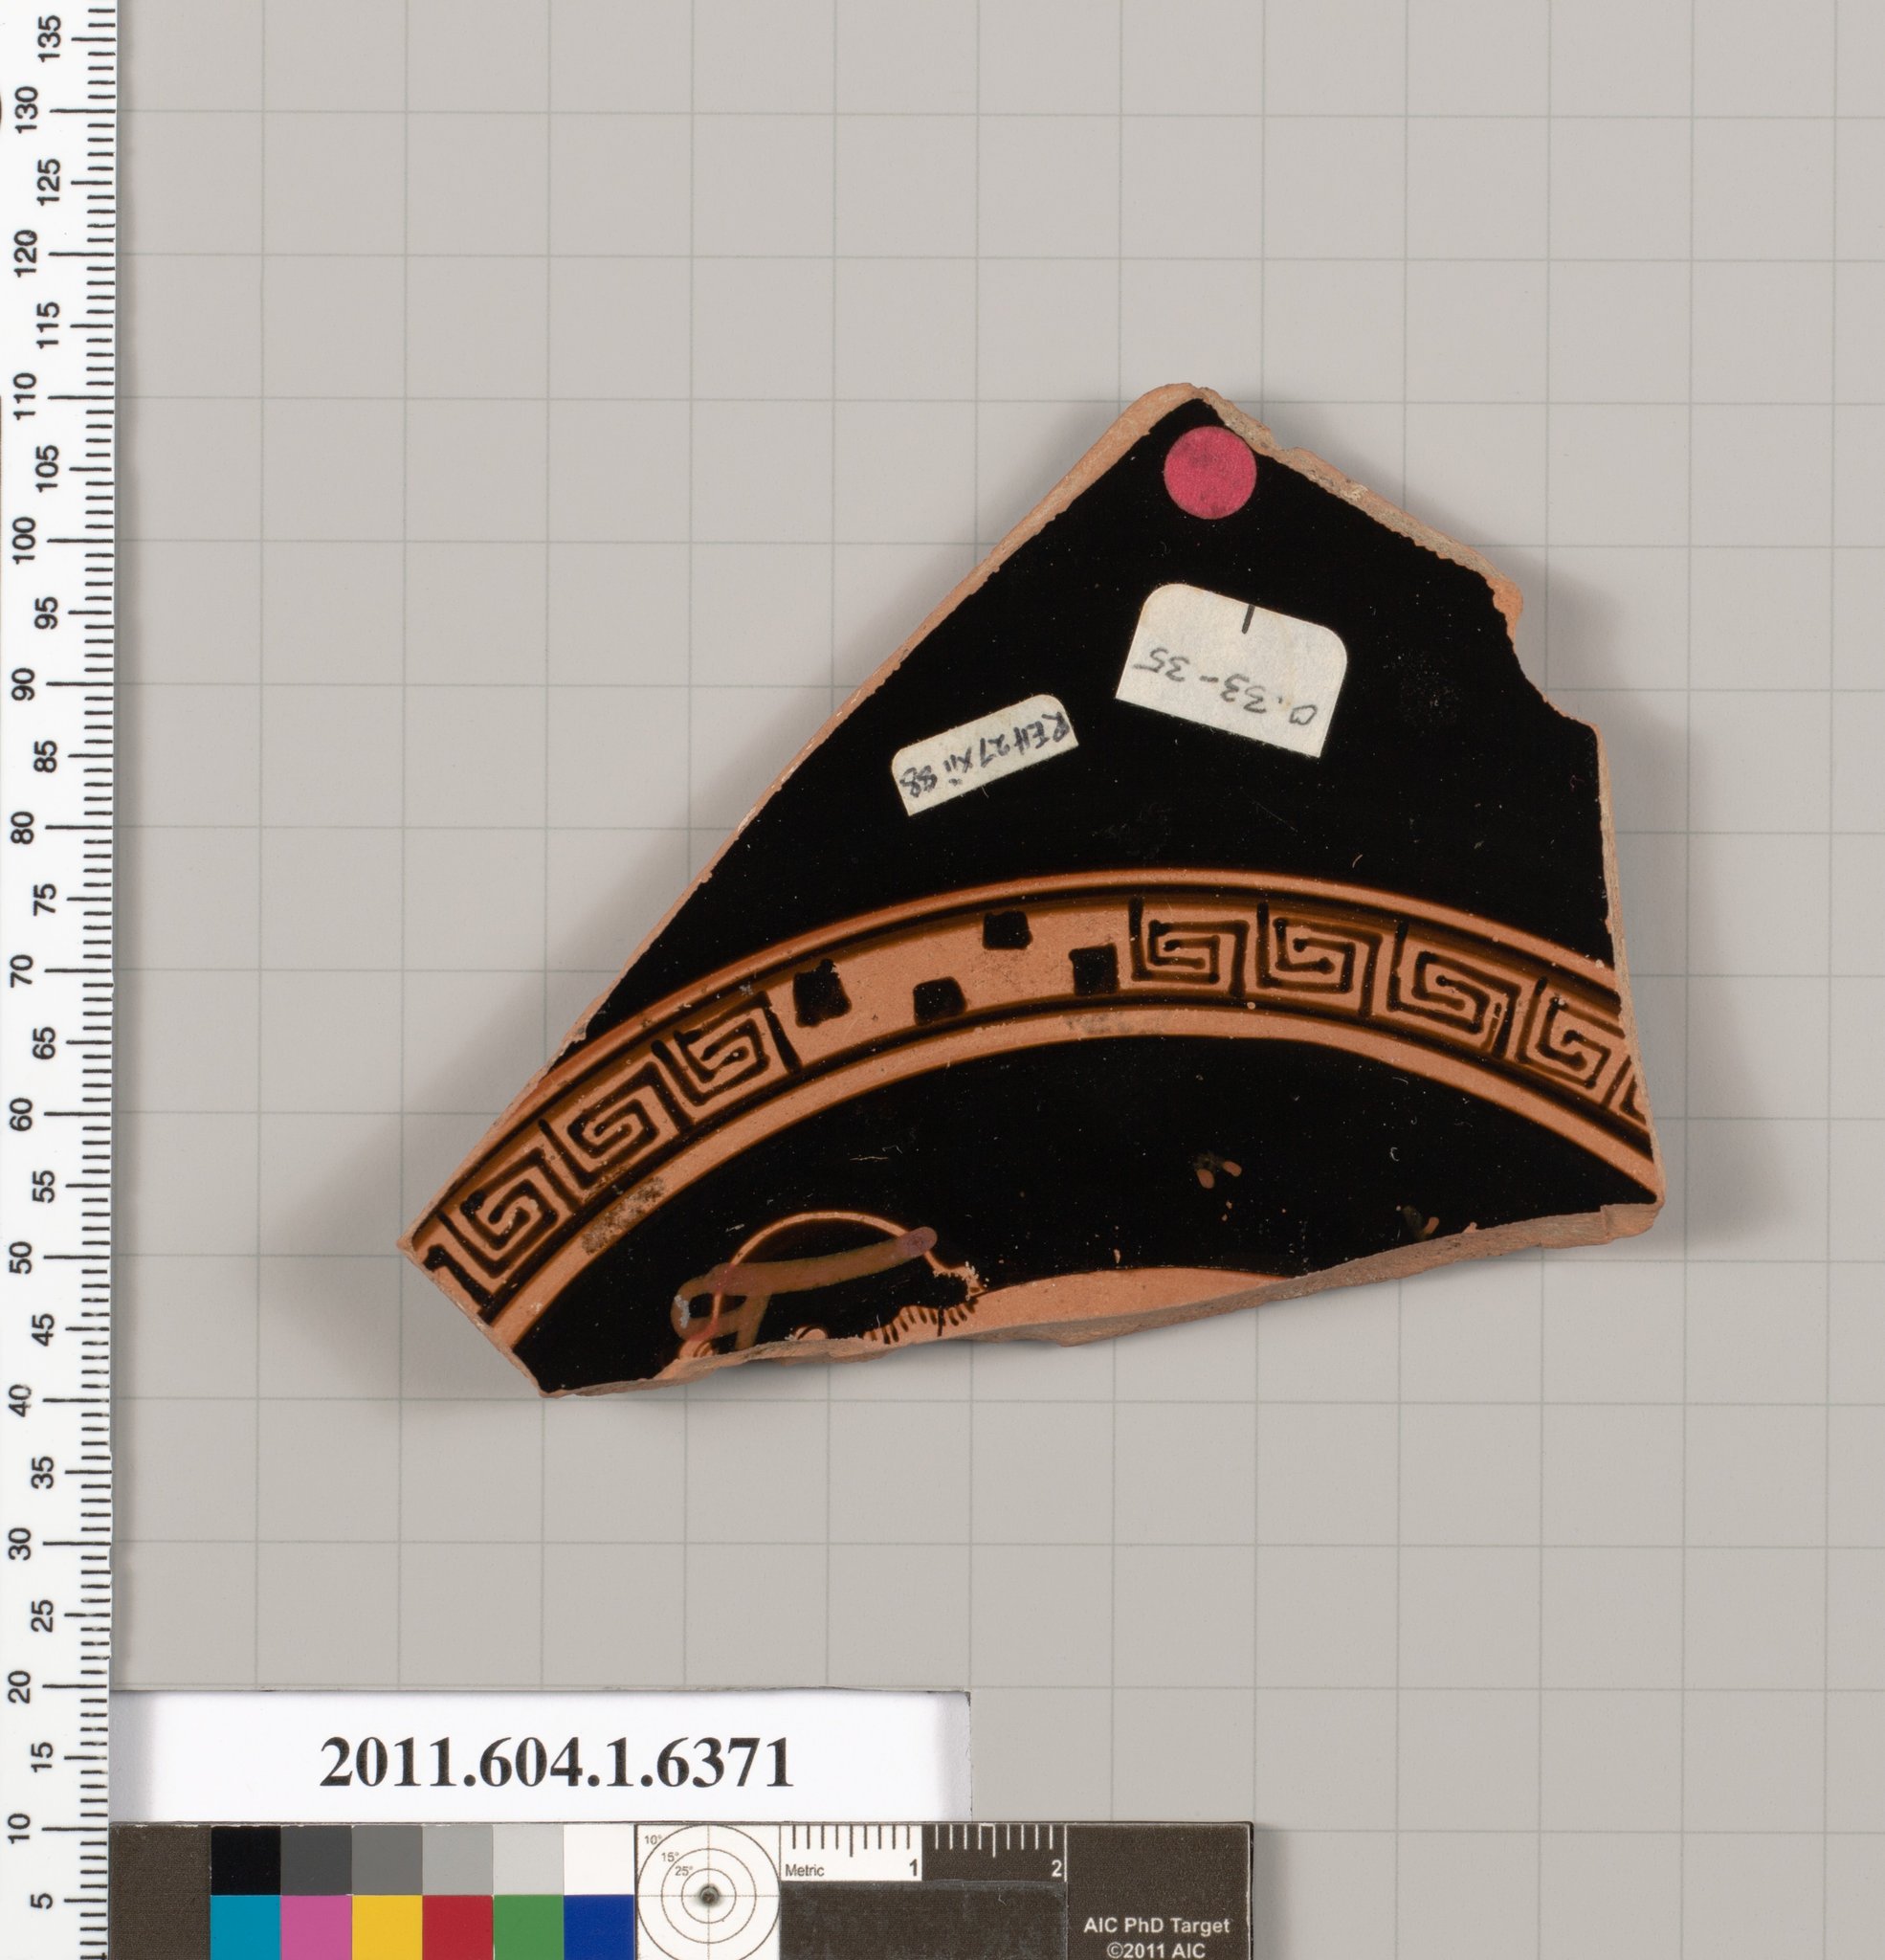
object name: kylix fragment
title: Terracotta fragment of a kylix (drinking cup)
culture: greek, attic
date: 490-480 BCE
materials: terracotta